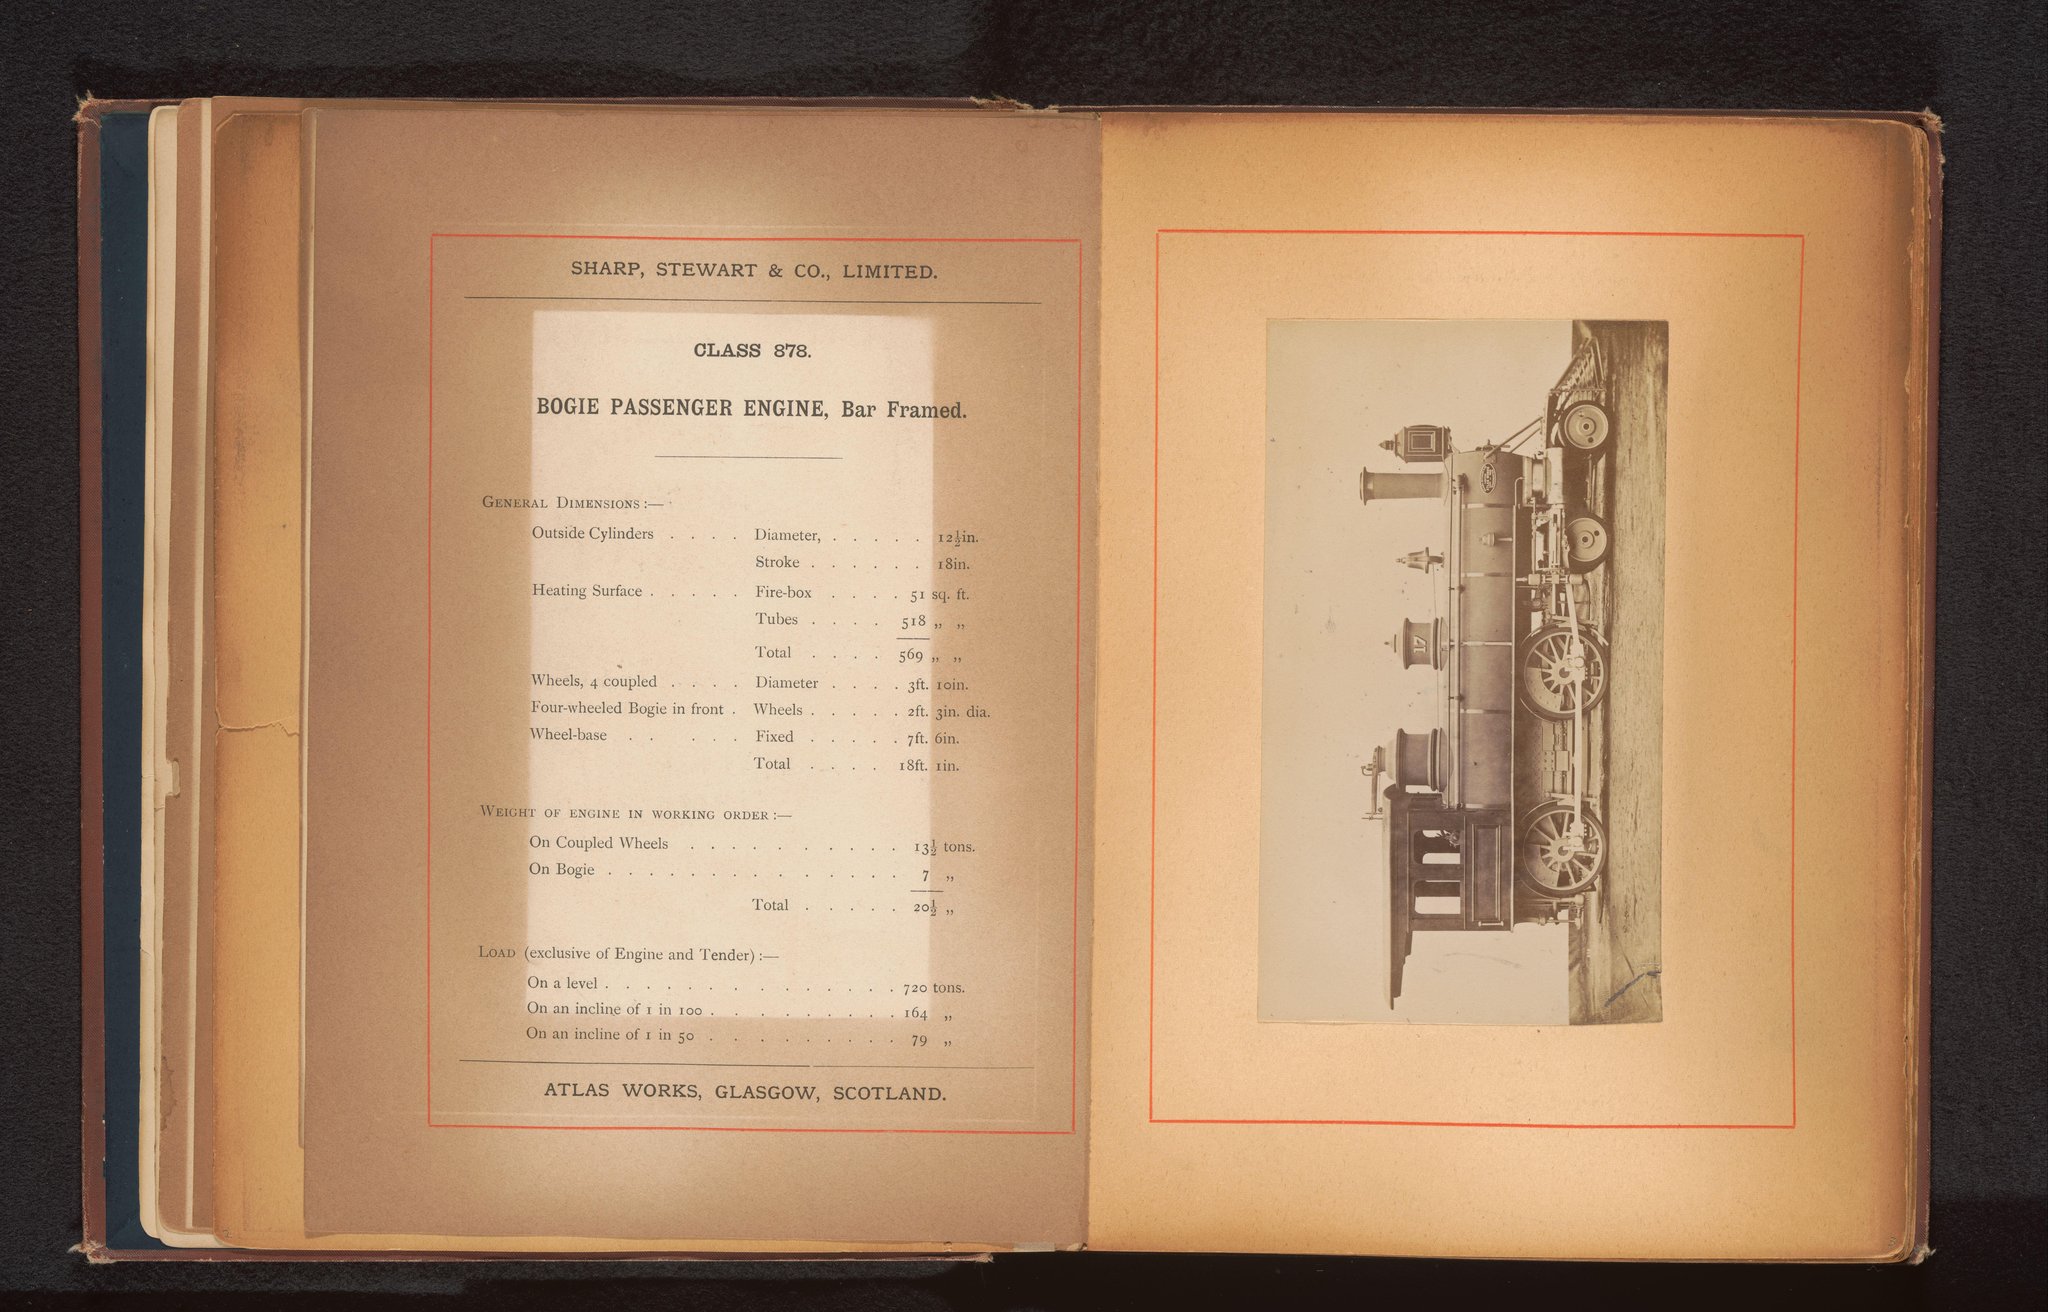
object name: photograph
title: Stoomlocomotief voor personenvervoer gemaakt door Sharp, Stewart and Company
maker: Anonymous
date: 1874-1884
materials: photographic support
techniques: albumen print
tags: steam locomotive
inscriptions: inscription: ‘Class 878. Bogie passenger engine, Bar Framed.’, number: ‘878’